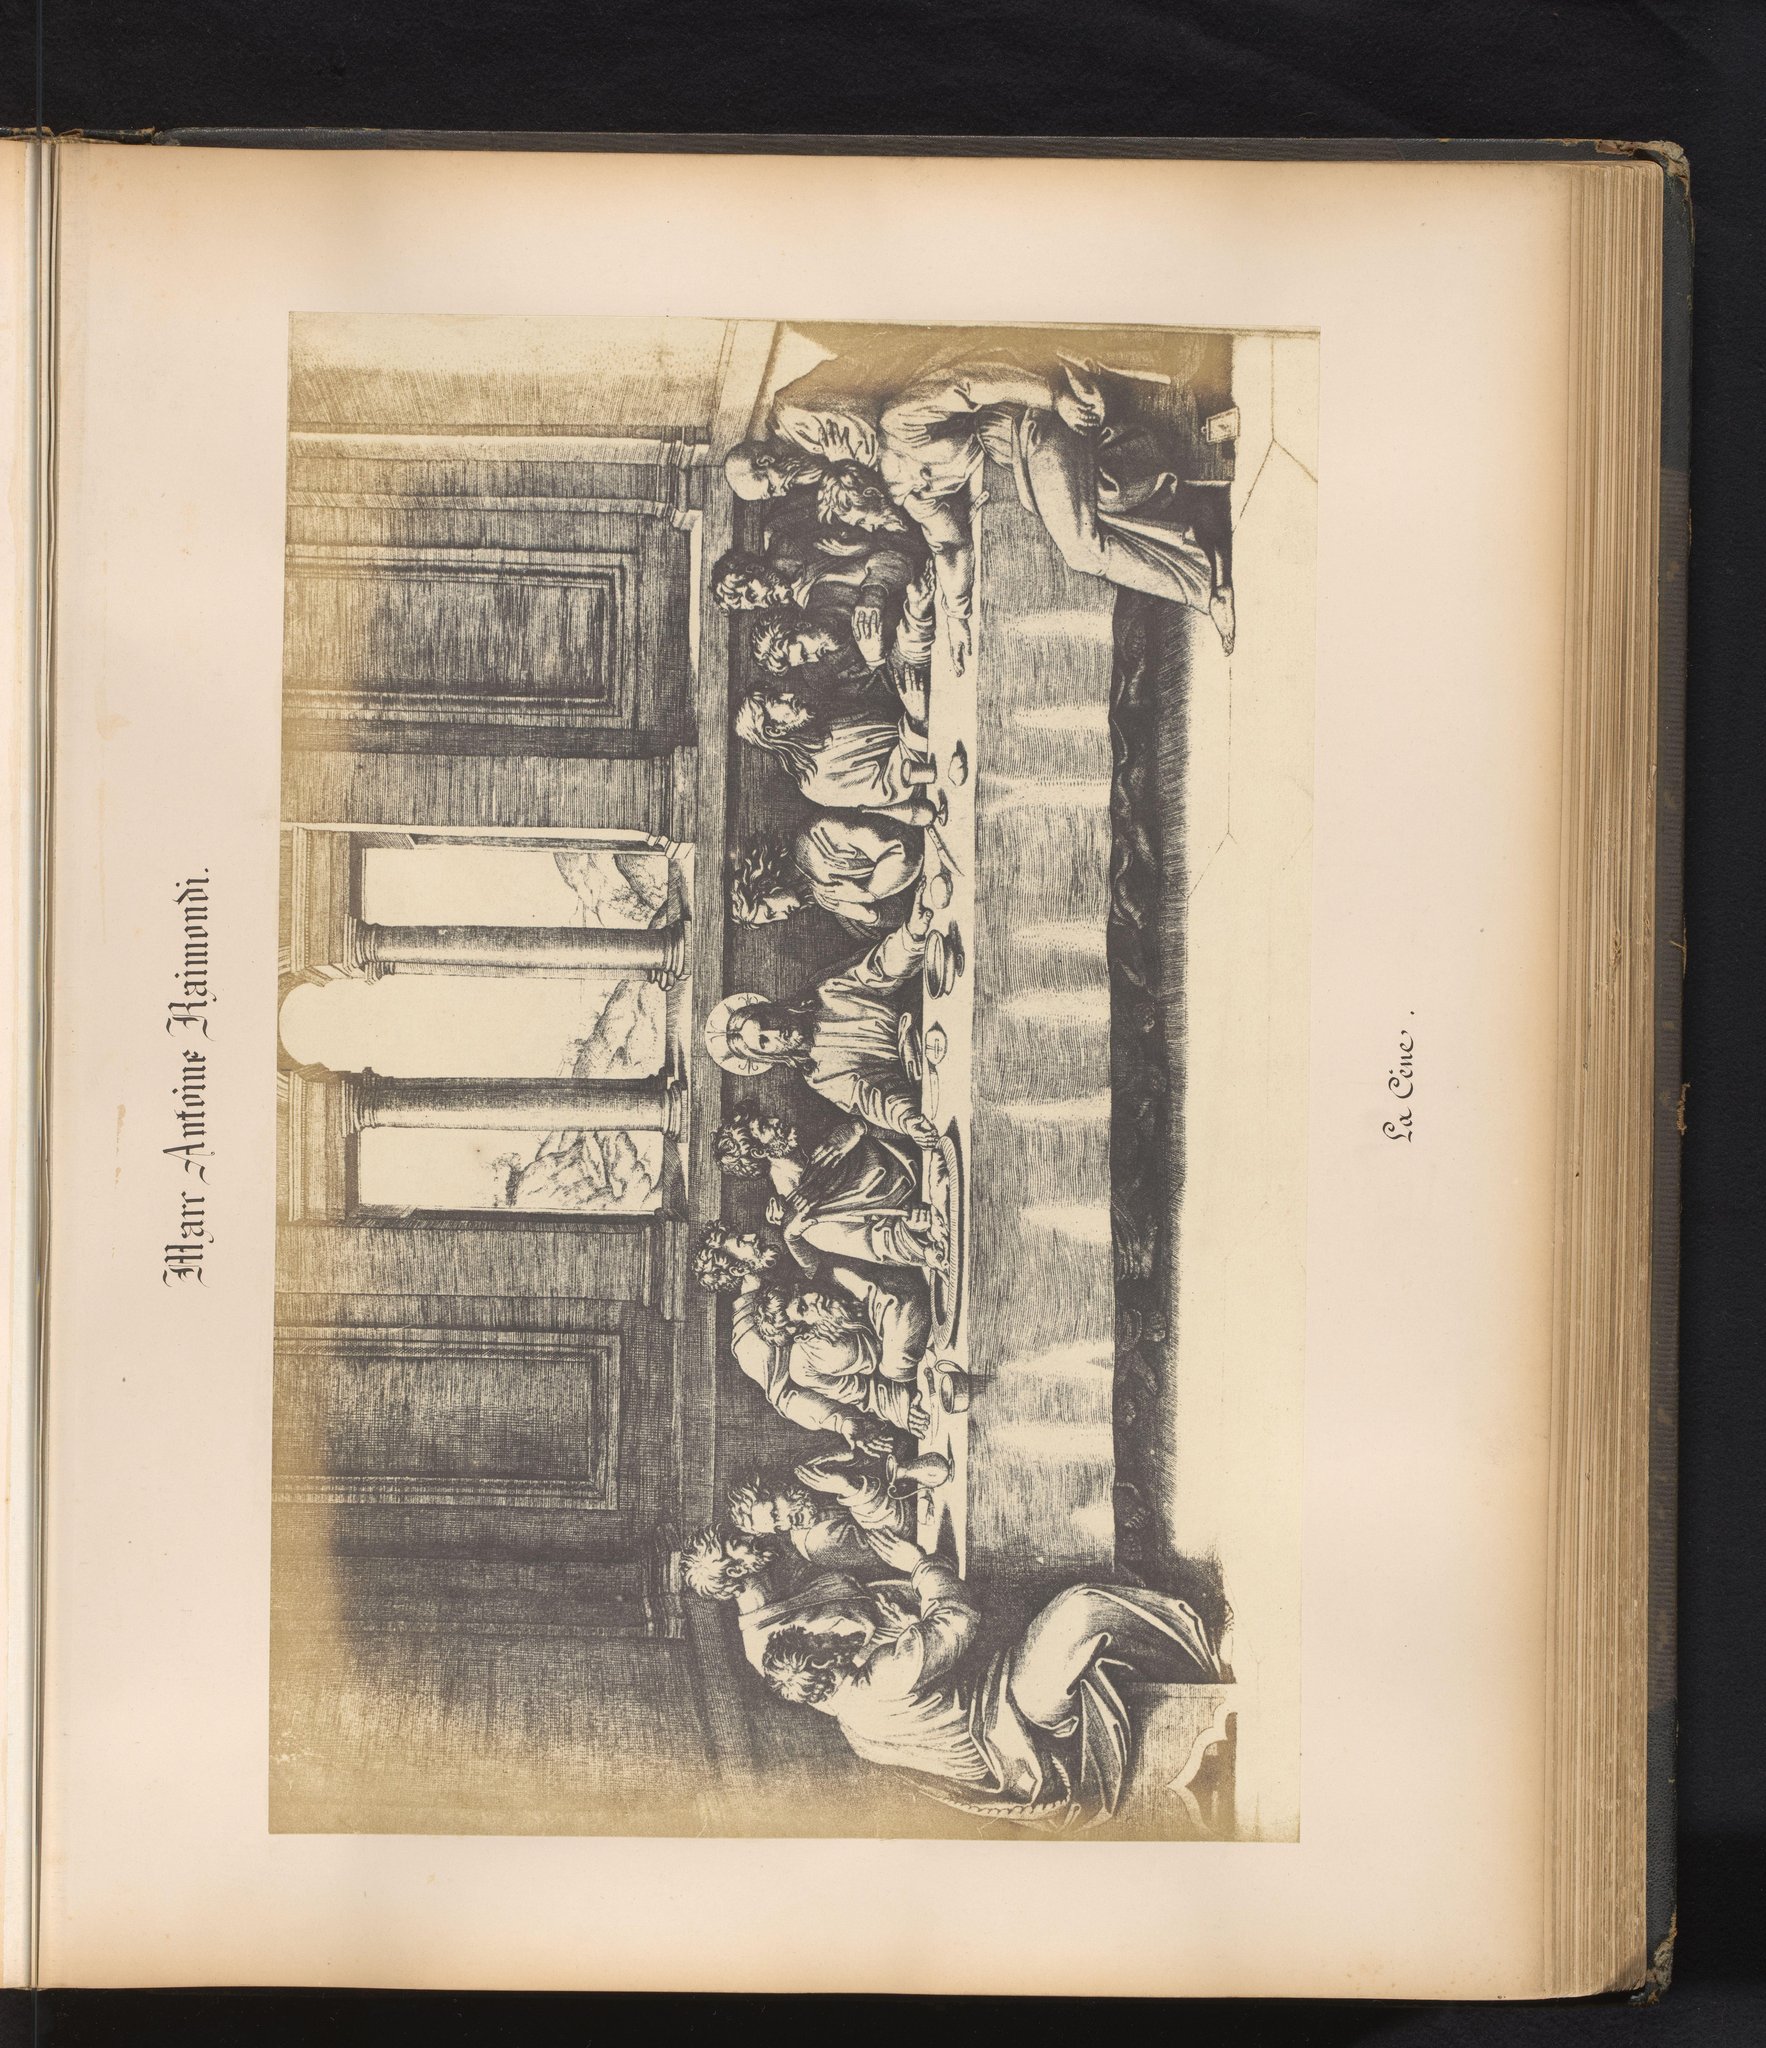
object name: photograph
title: Fotoreproductie van een gravure van het Laatste avondmaal door Marcantonio Raimondi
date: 1848-1853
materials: photographic support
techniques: salted paper print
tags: last supper (in general) (matthew 26:21-35; mark 14:18-31; luke 22:3, 22:15-23; john 13:21-38)